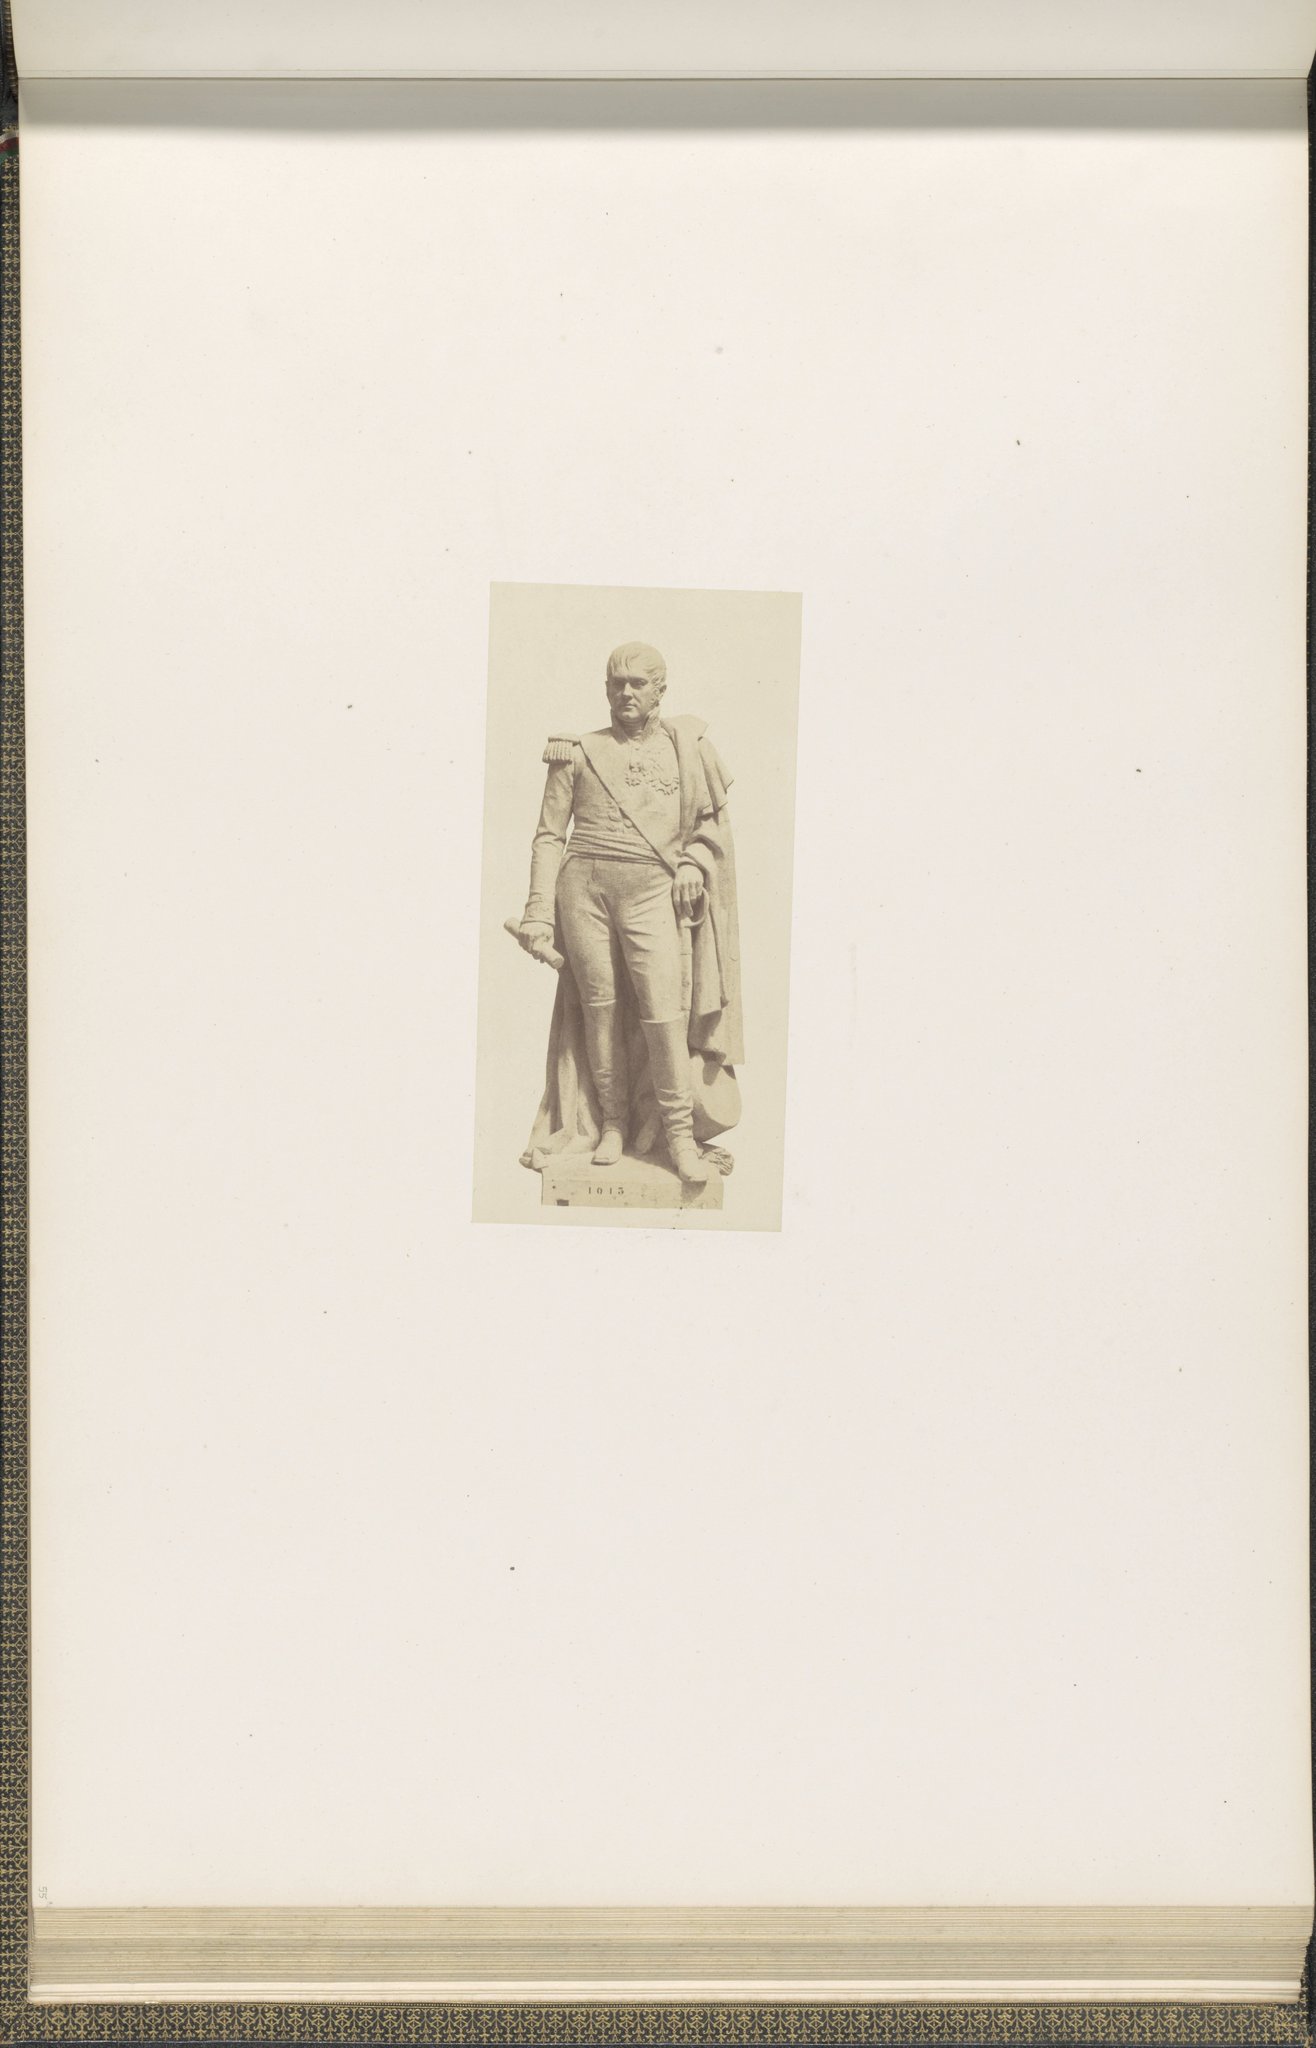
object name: photograph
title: Gipsmodel voor beeldhouwwerk op het Palais du Louvre: "Ney" door Pierre Hébert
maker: édouard denis baldus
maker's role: fotograaf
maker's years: 1813-1889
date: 1855-1857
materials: paper, photographic support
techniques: salted paper print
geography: paris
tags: piece of sculpture, reproduction of a piece of sculpture, permanent exhibition, museum, paris, tuileries palace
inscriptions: number: ‘1013’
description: Onderdeel van Réunion des Tuileries au Louvre 1852-1857, album 4.